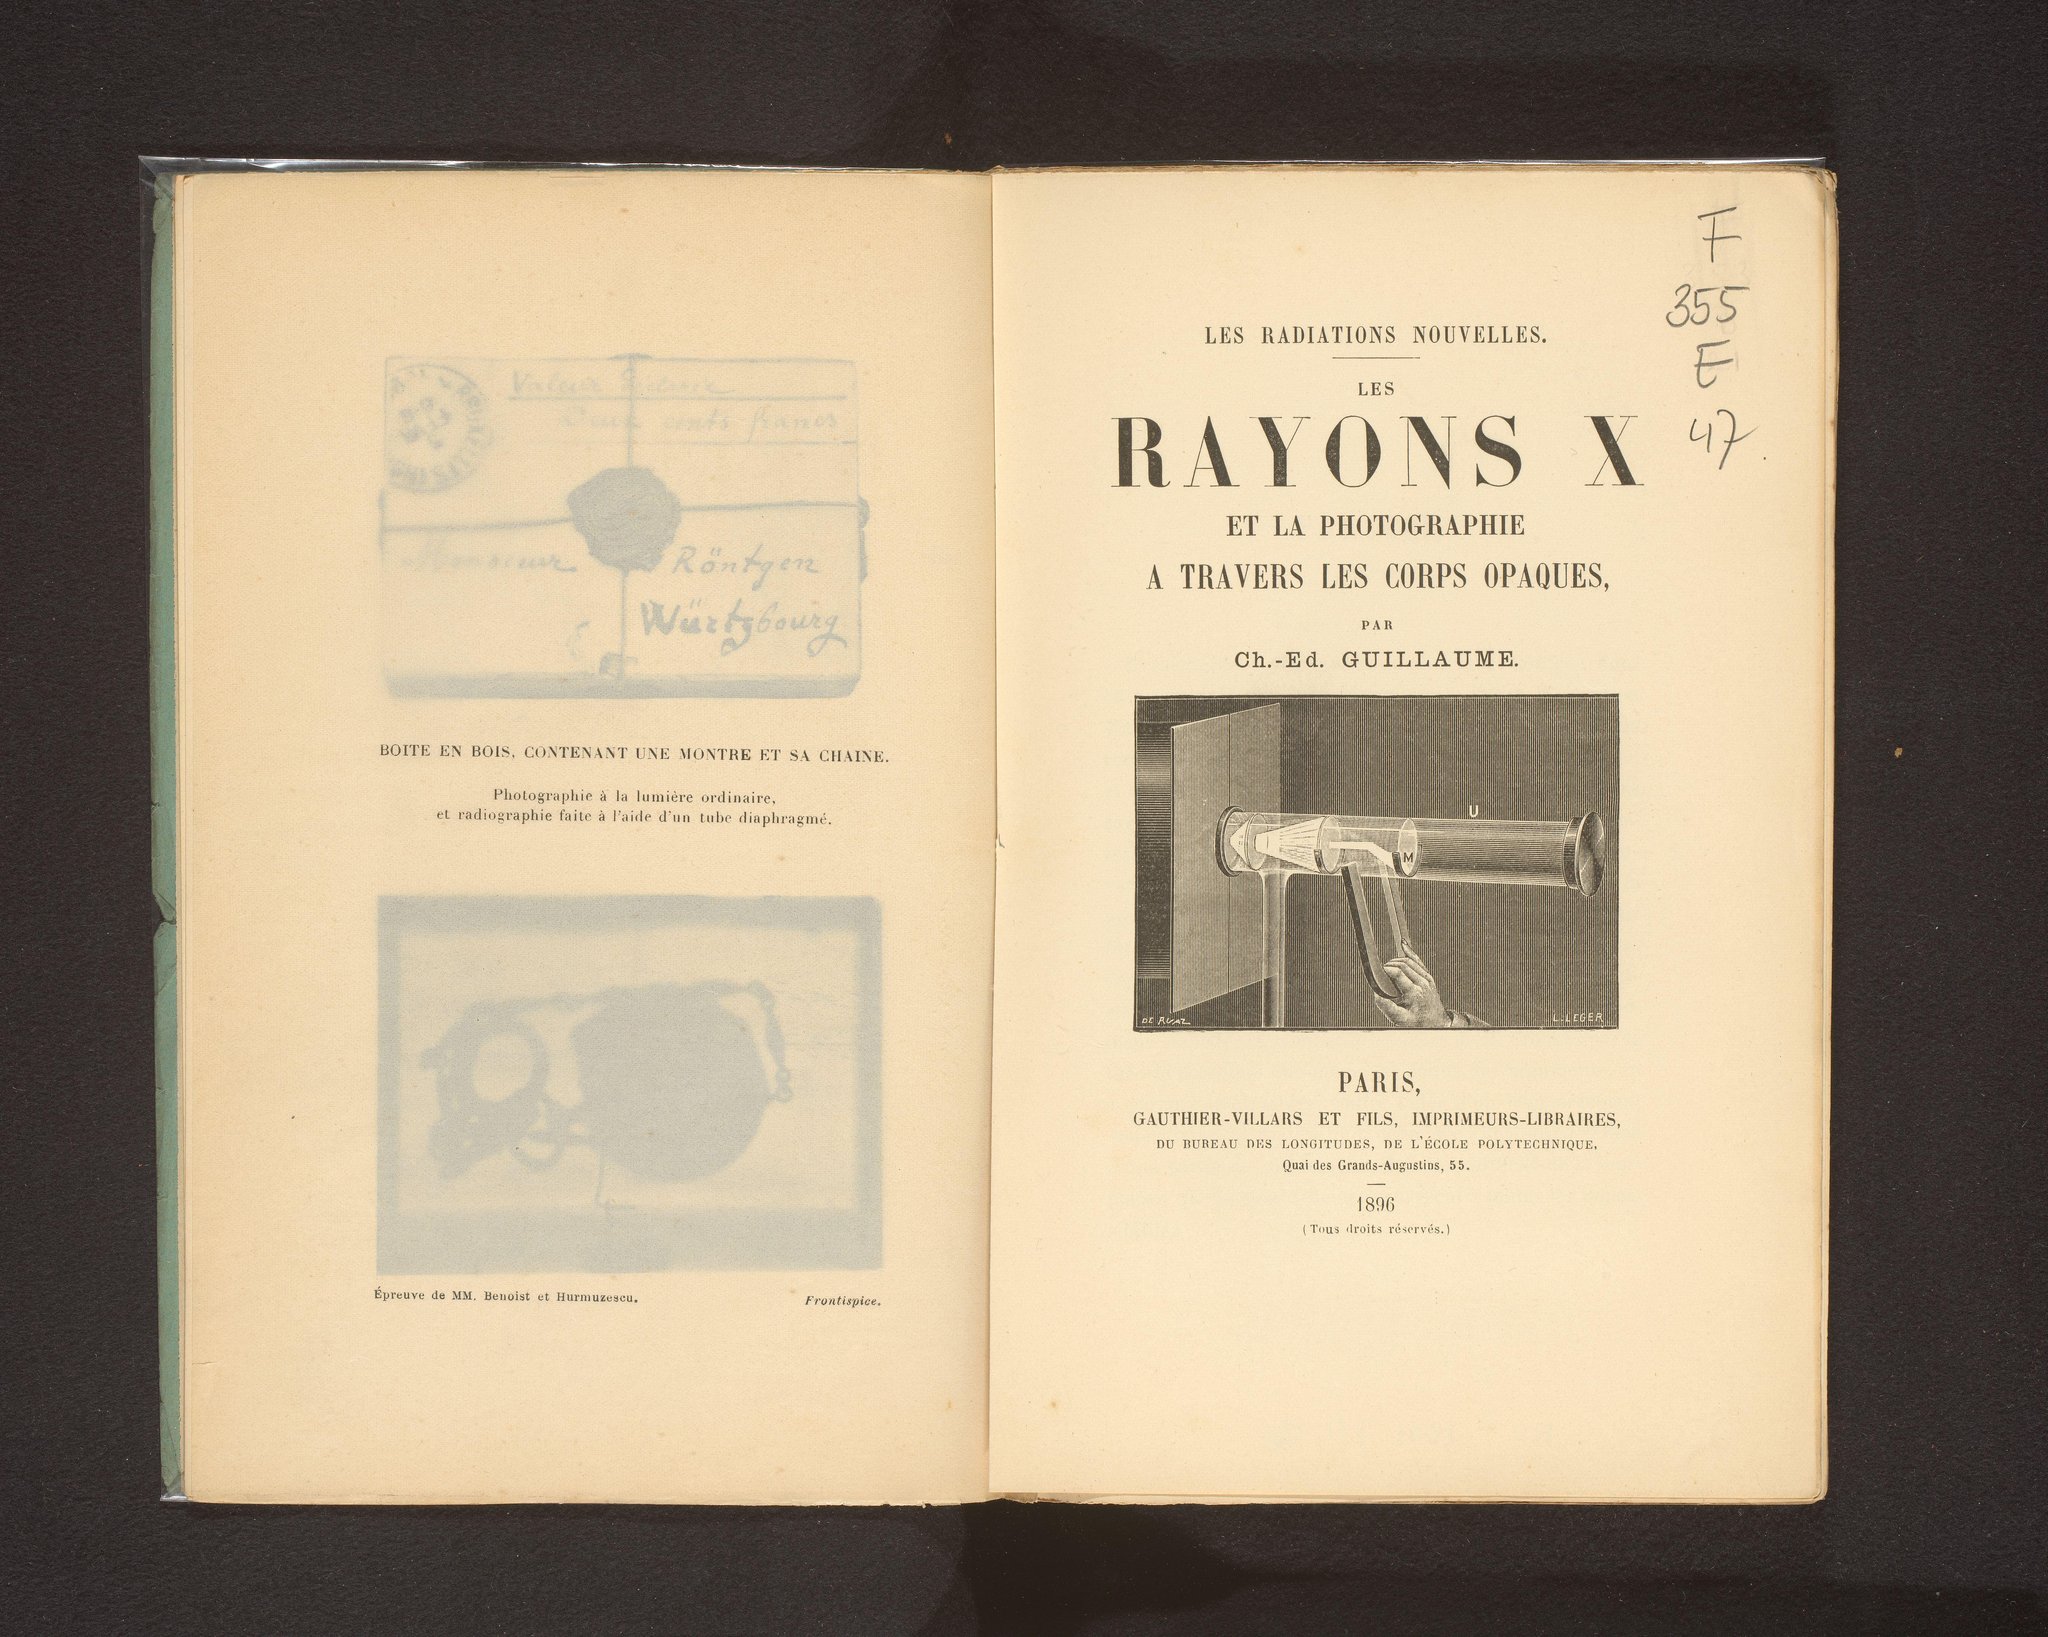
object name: book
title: Les rayons X et la photographie à travers les corps opaquese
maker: charles-édouard guillaume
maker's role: physicist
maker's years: 1861-1938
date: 1896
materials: paper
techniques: photograph, printing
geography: paris